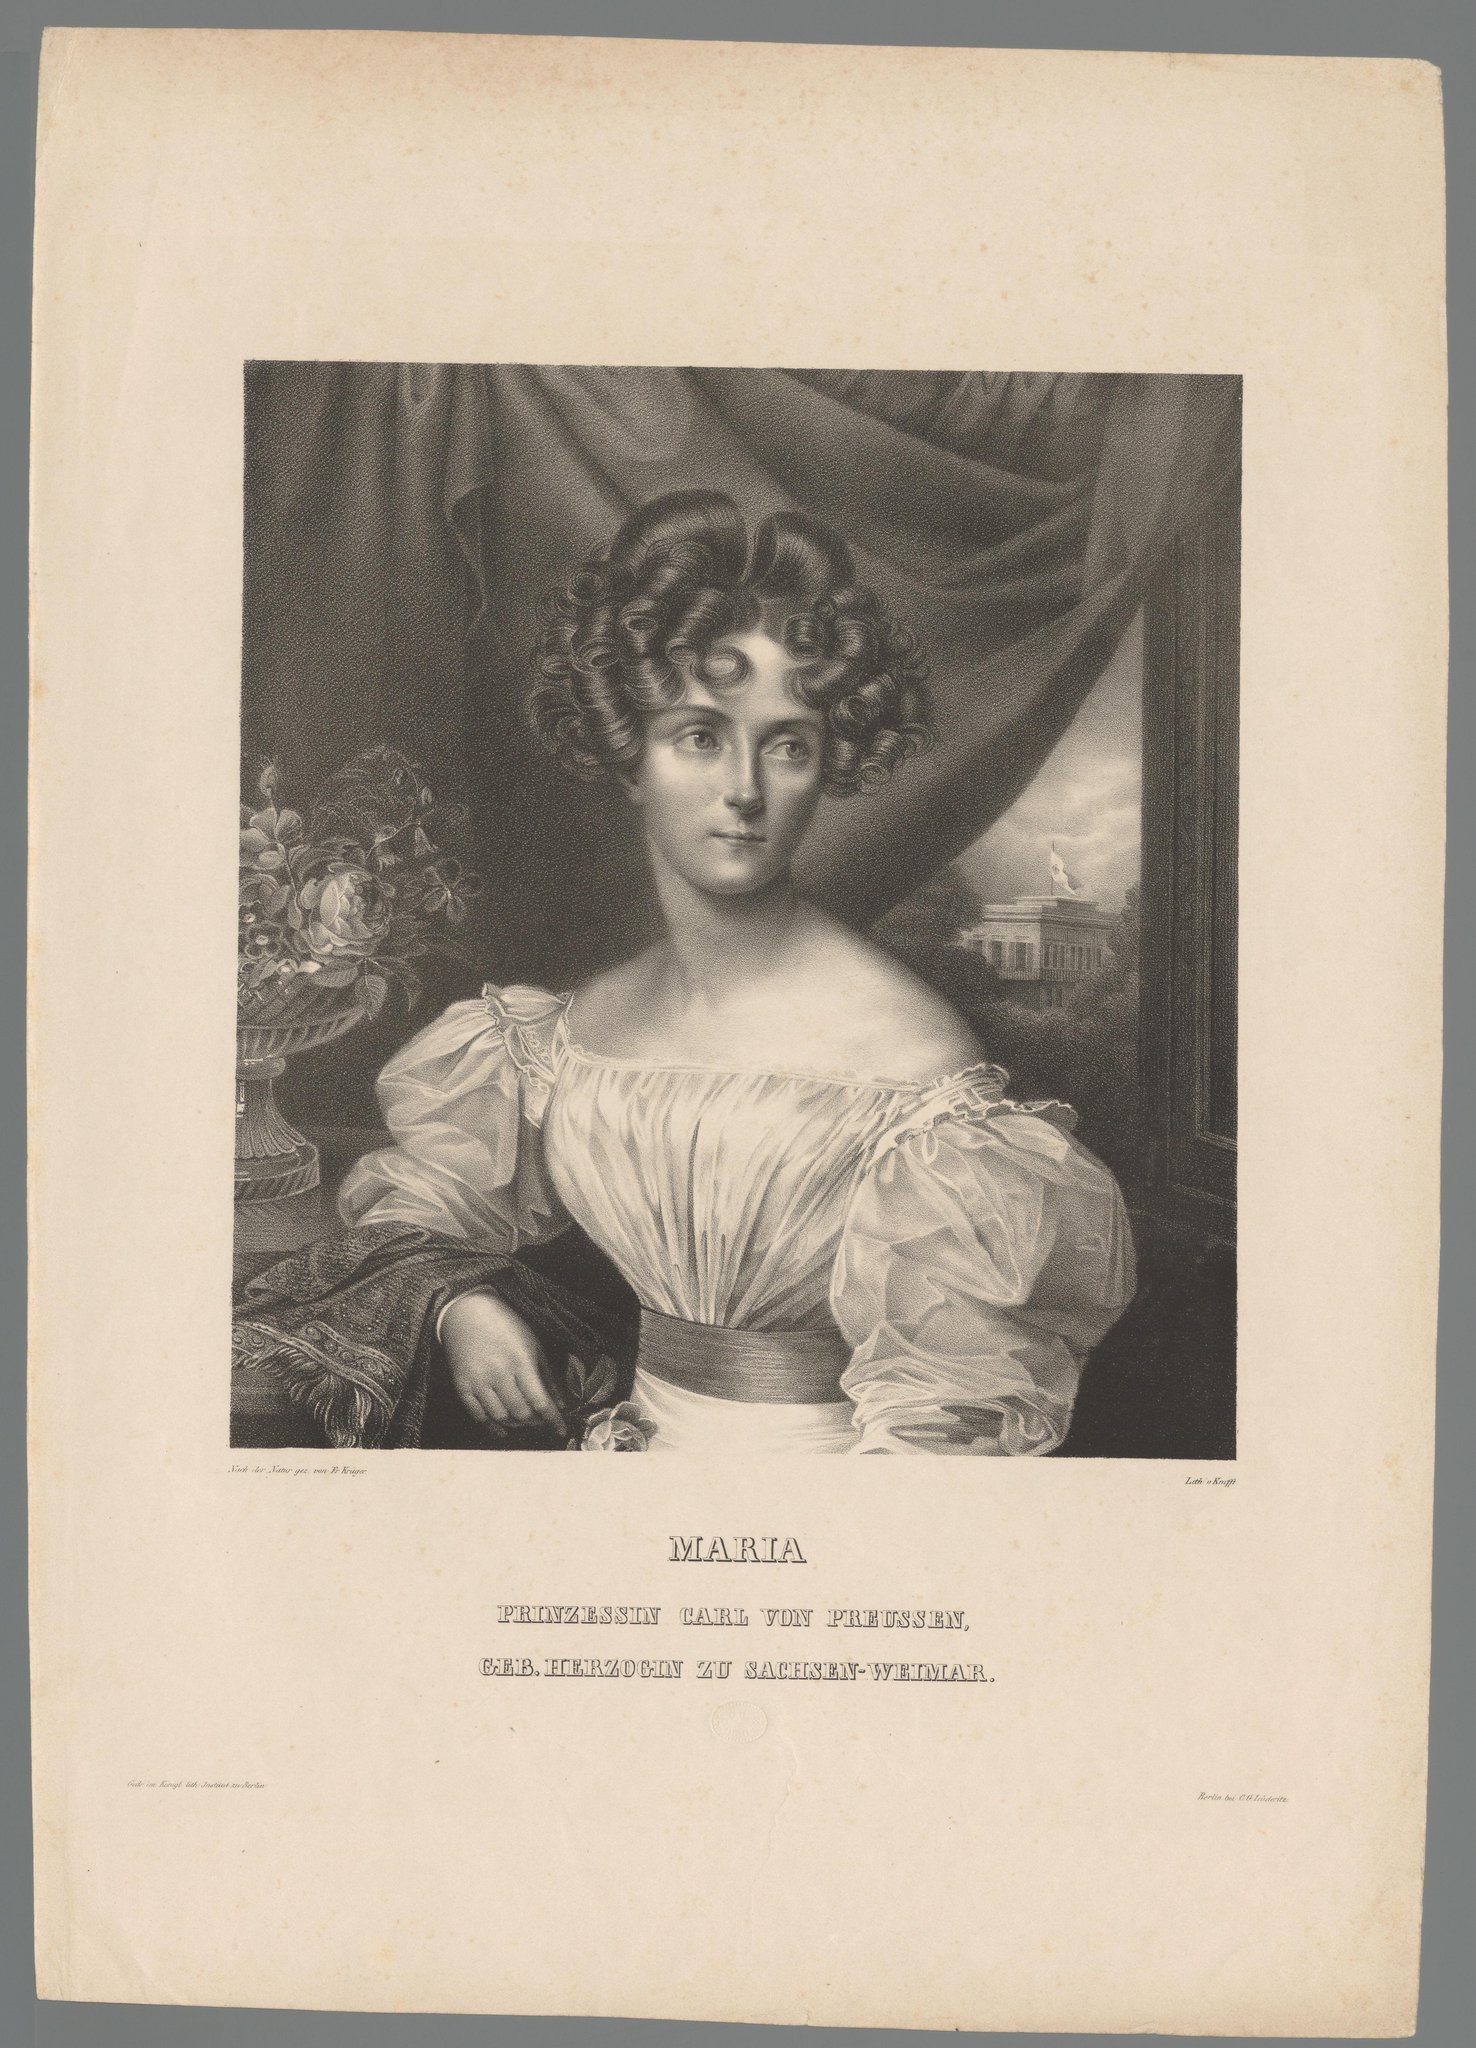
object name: print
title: Portret van Maria prinses van Pruisen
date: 1807-1840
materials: paper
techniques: lithograph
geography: berlin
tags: berlin, historical persons, princess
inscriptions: collector's mark: Lugt 2228, check stamp: Lugt 4519